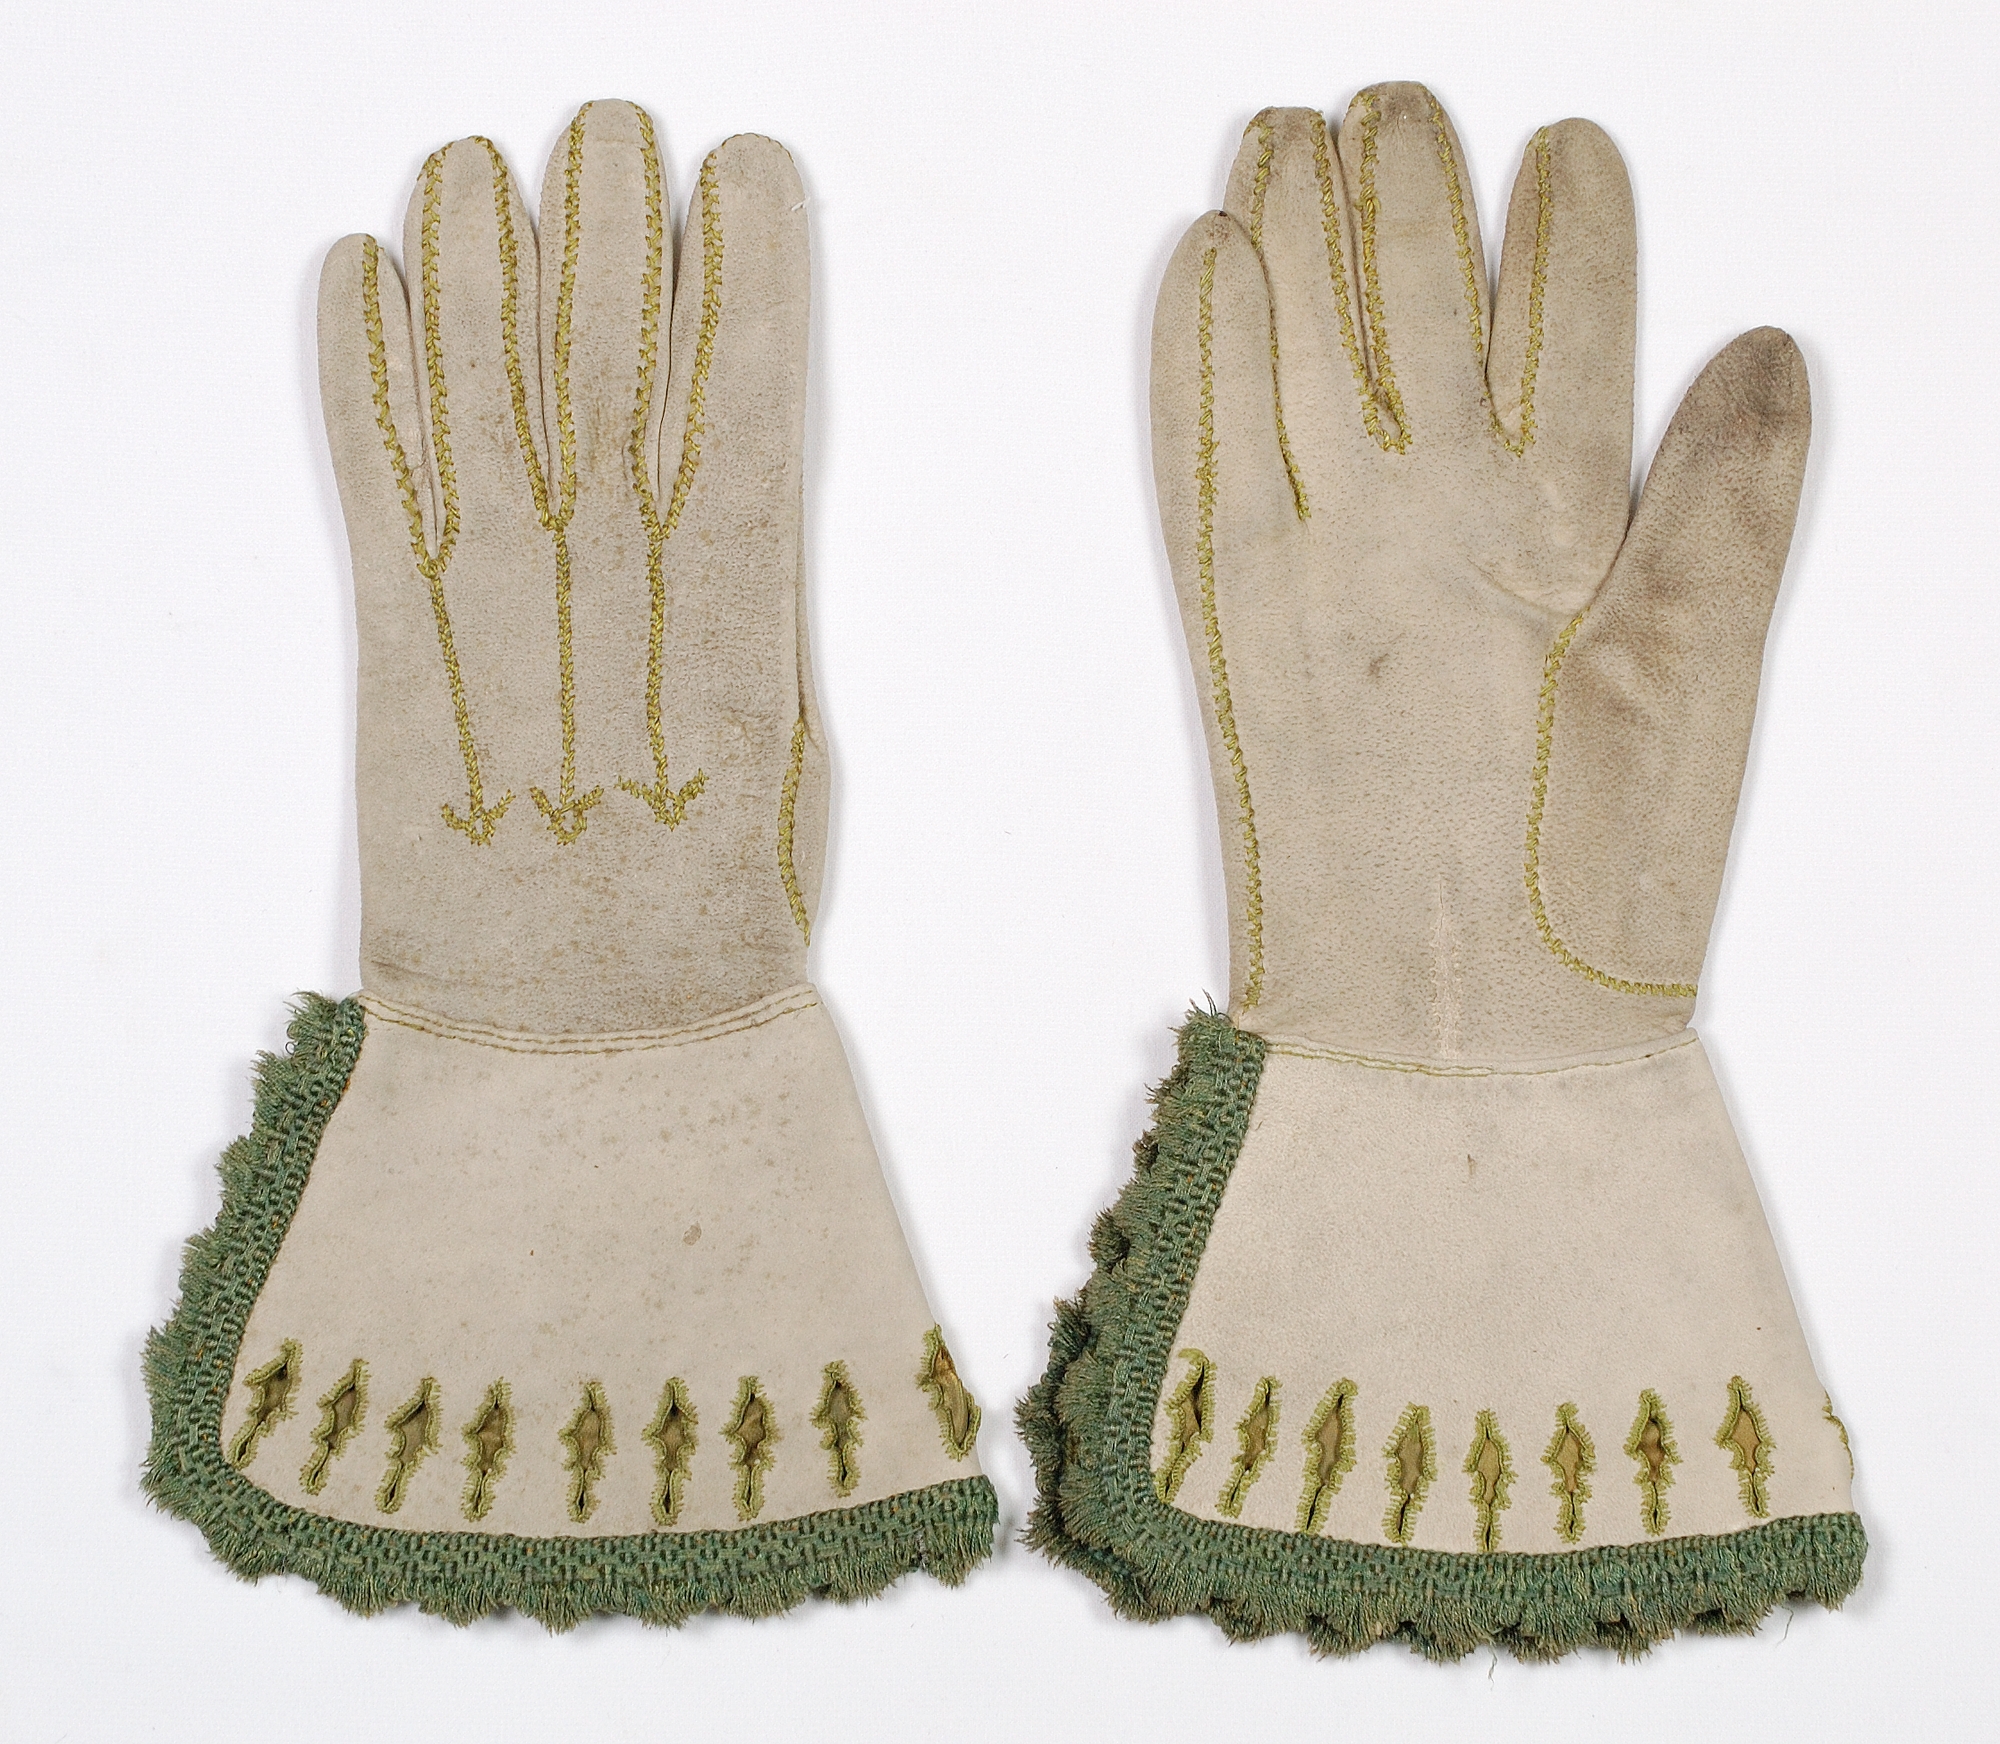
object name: glove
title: Gloves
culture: french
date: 1726-1750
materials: leather, silk